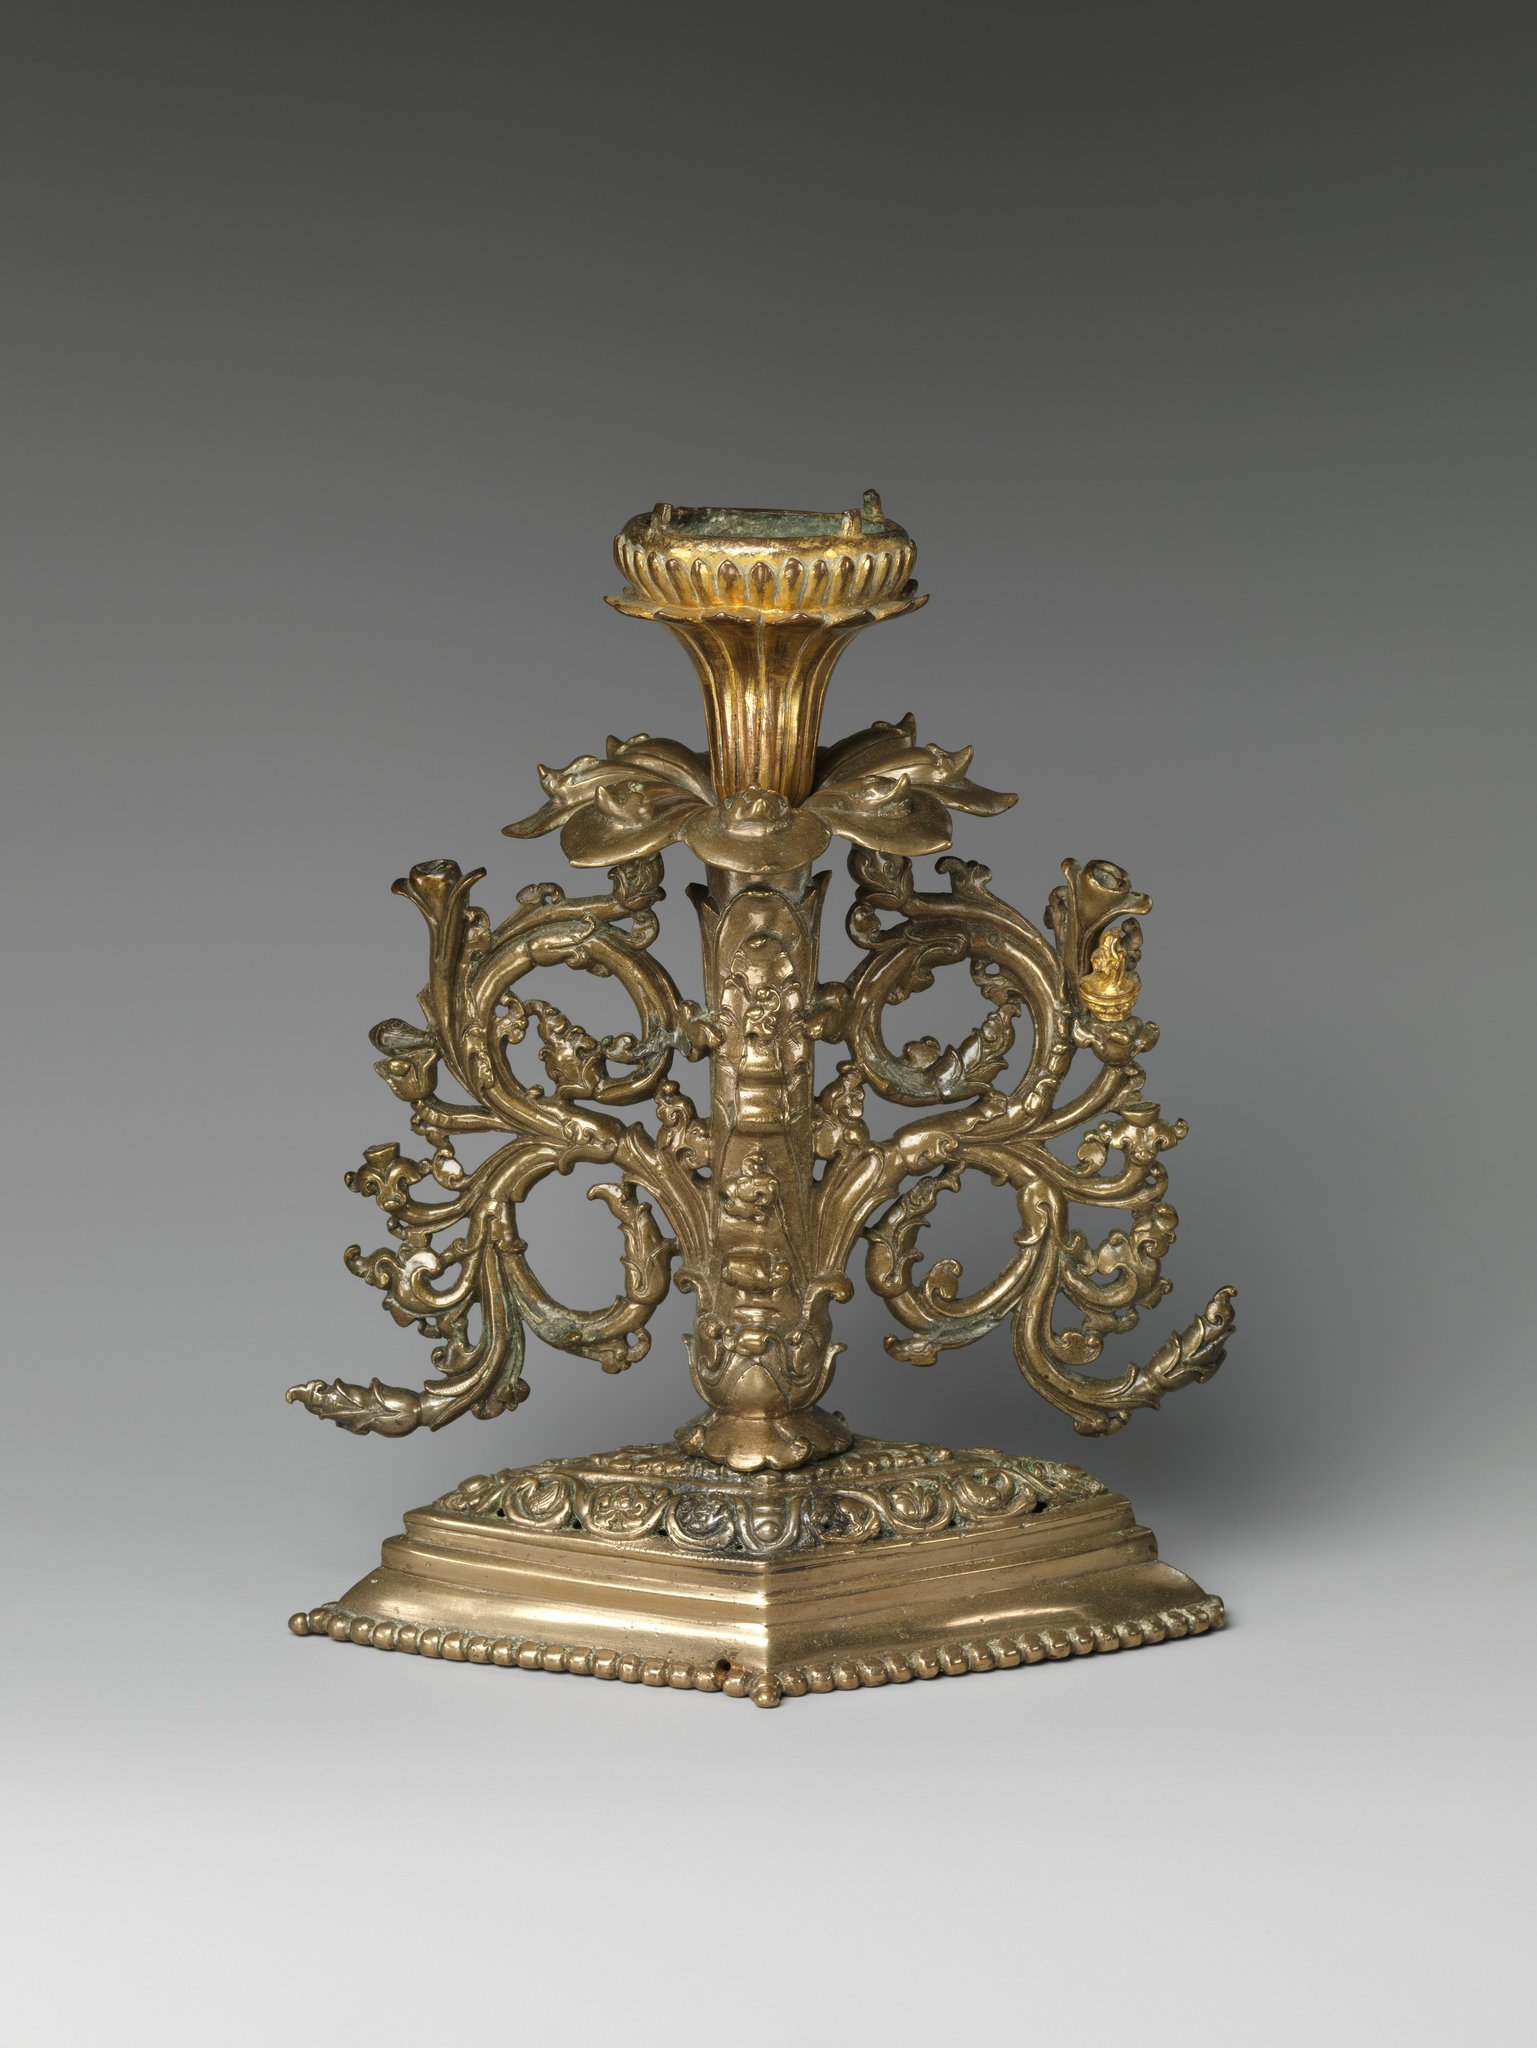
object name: pedestal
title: Foliate Pedestal for a Buddhist Image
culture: indian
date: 1167-1200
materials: copper, gilt brass